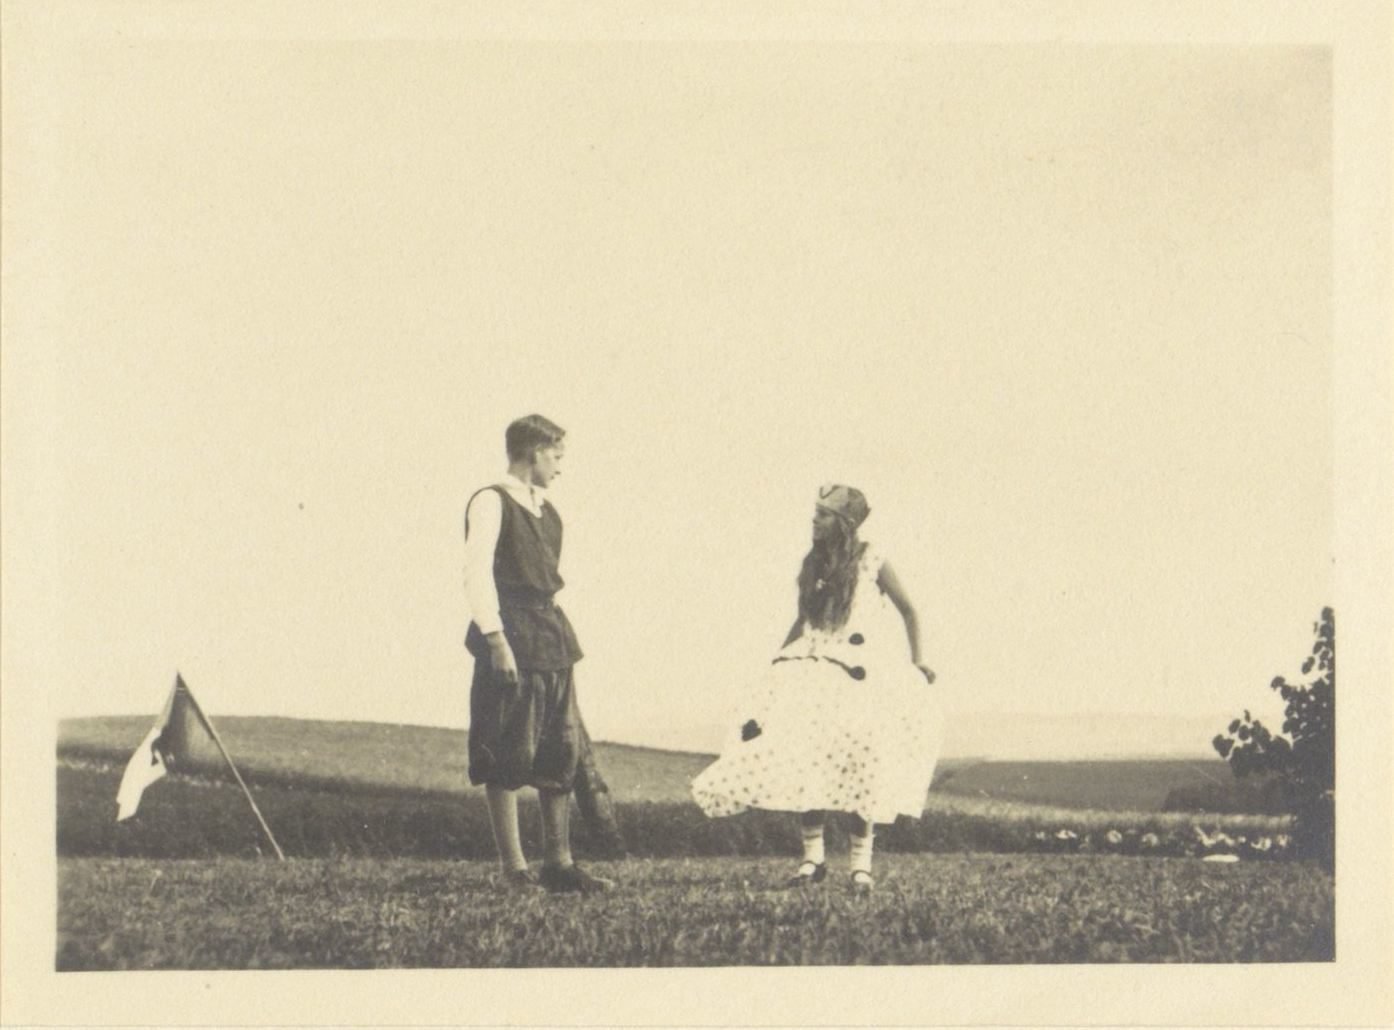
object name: photograph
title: Jonge leerlingen van Hermannsberg, een nevenvestiging van Schule Schloss Salem, tijdens een uitvoering in de openlucht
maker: Anonymous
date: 1929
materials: photographic support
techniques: gelatin silver print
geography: hermannsberg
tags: performance, theatre, theatrical performance, historical costume, education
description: Onderdeel van Fotoalbum van Schule Schloss Salem.